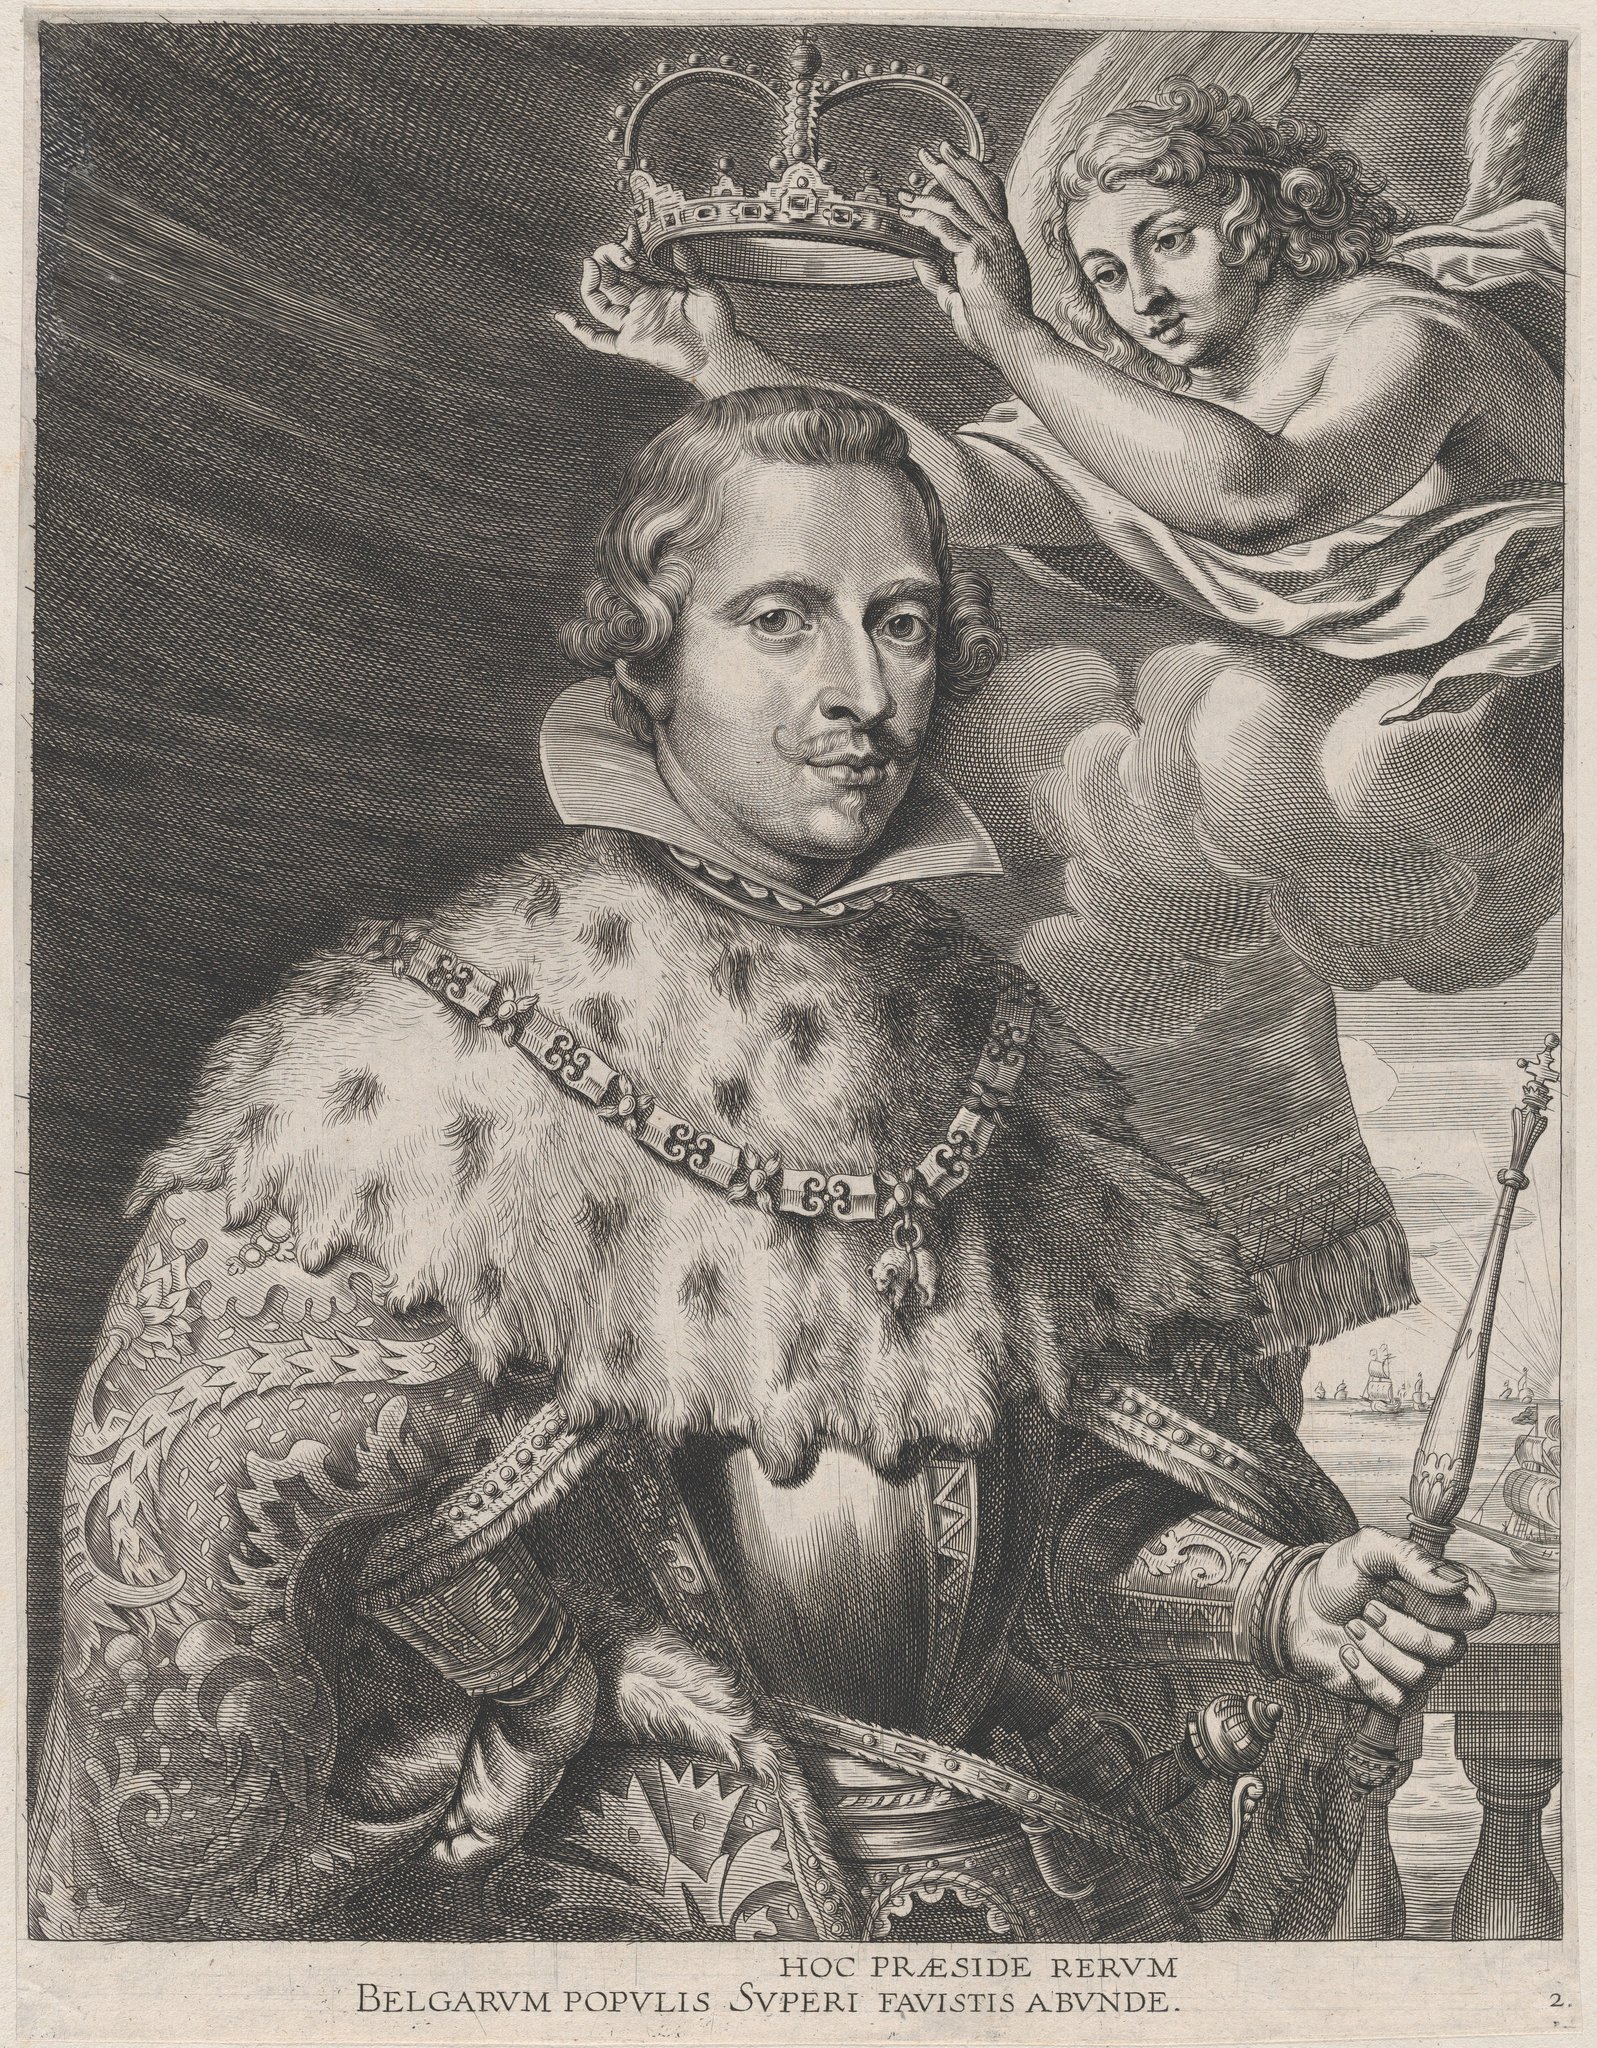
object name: print, fete, ornament architecture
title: Plate 2: Portrait of Philip IV, King of Spain, being crowned; from Guillielmus Becanus's 'Serenissimi Principis Ferdinandi, Hispaniarum Infantis...'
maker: johannes meursius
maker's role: publisher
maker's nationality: flemish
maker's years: 1600-1699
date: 1636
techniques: engraving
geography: antwerp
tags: philip iv,men,portraits,crowns